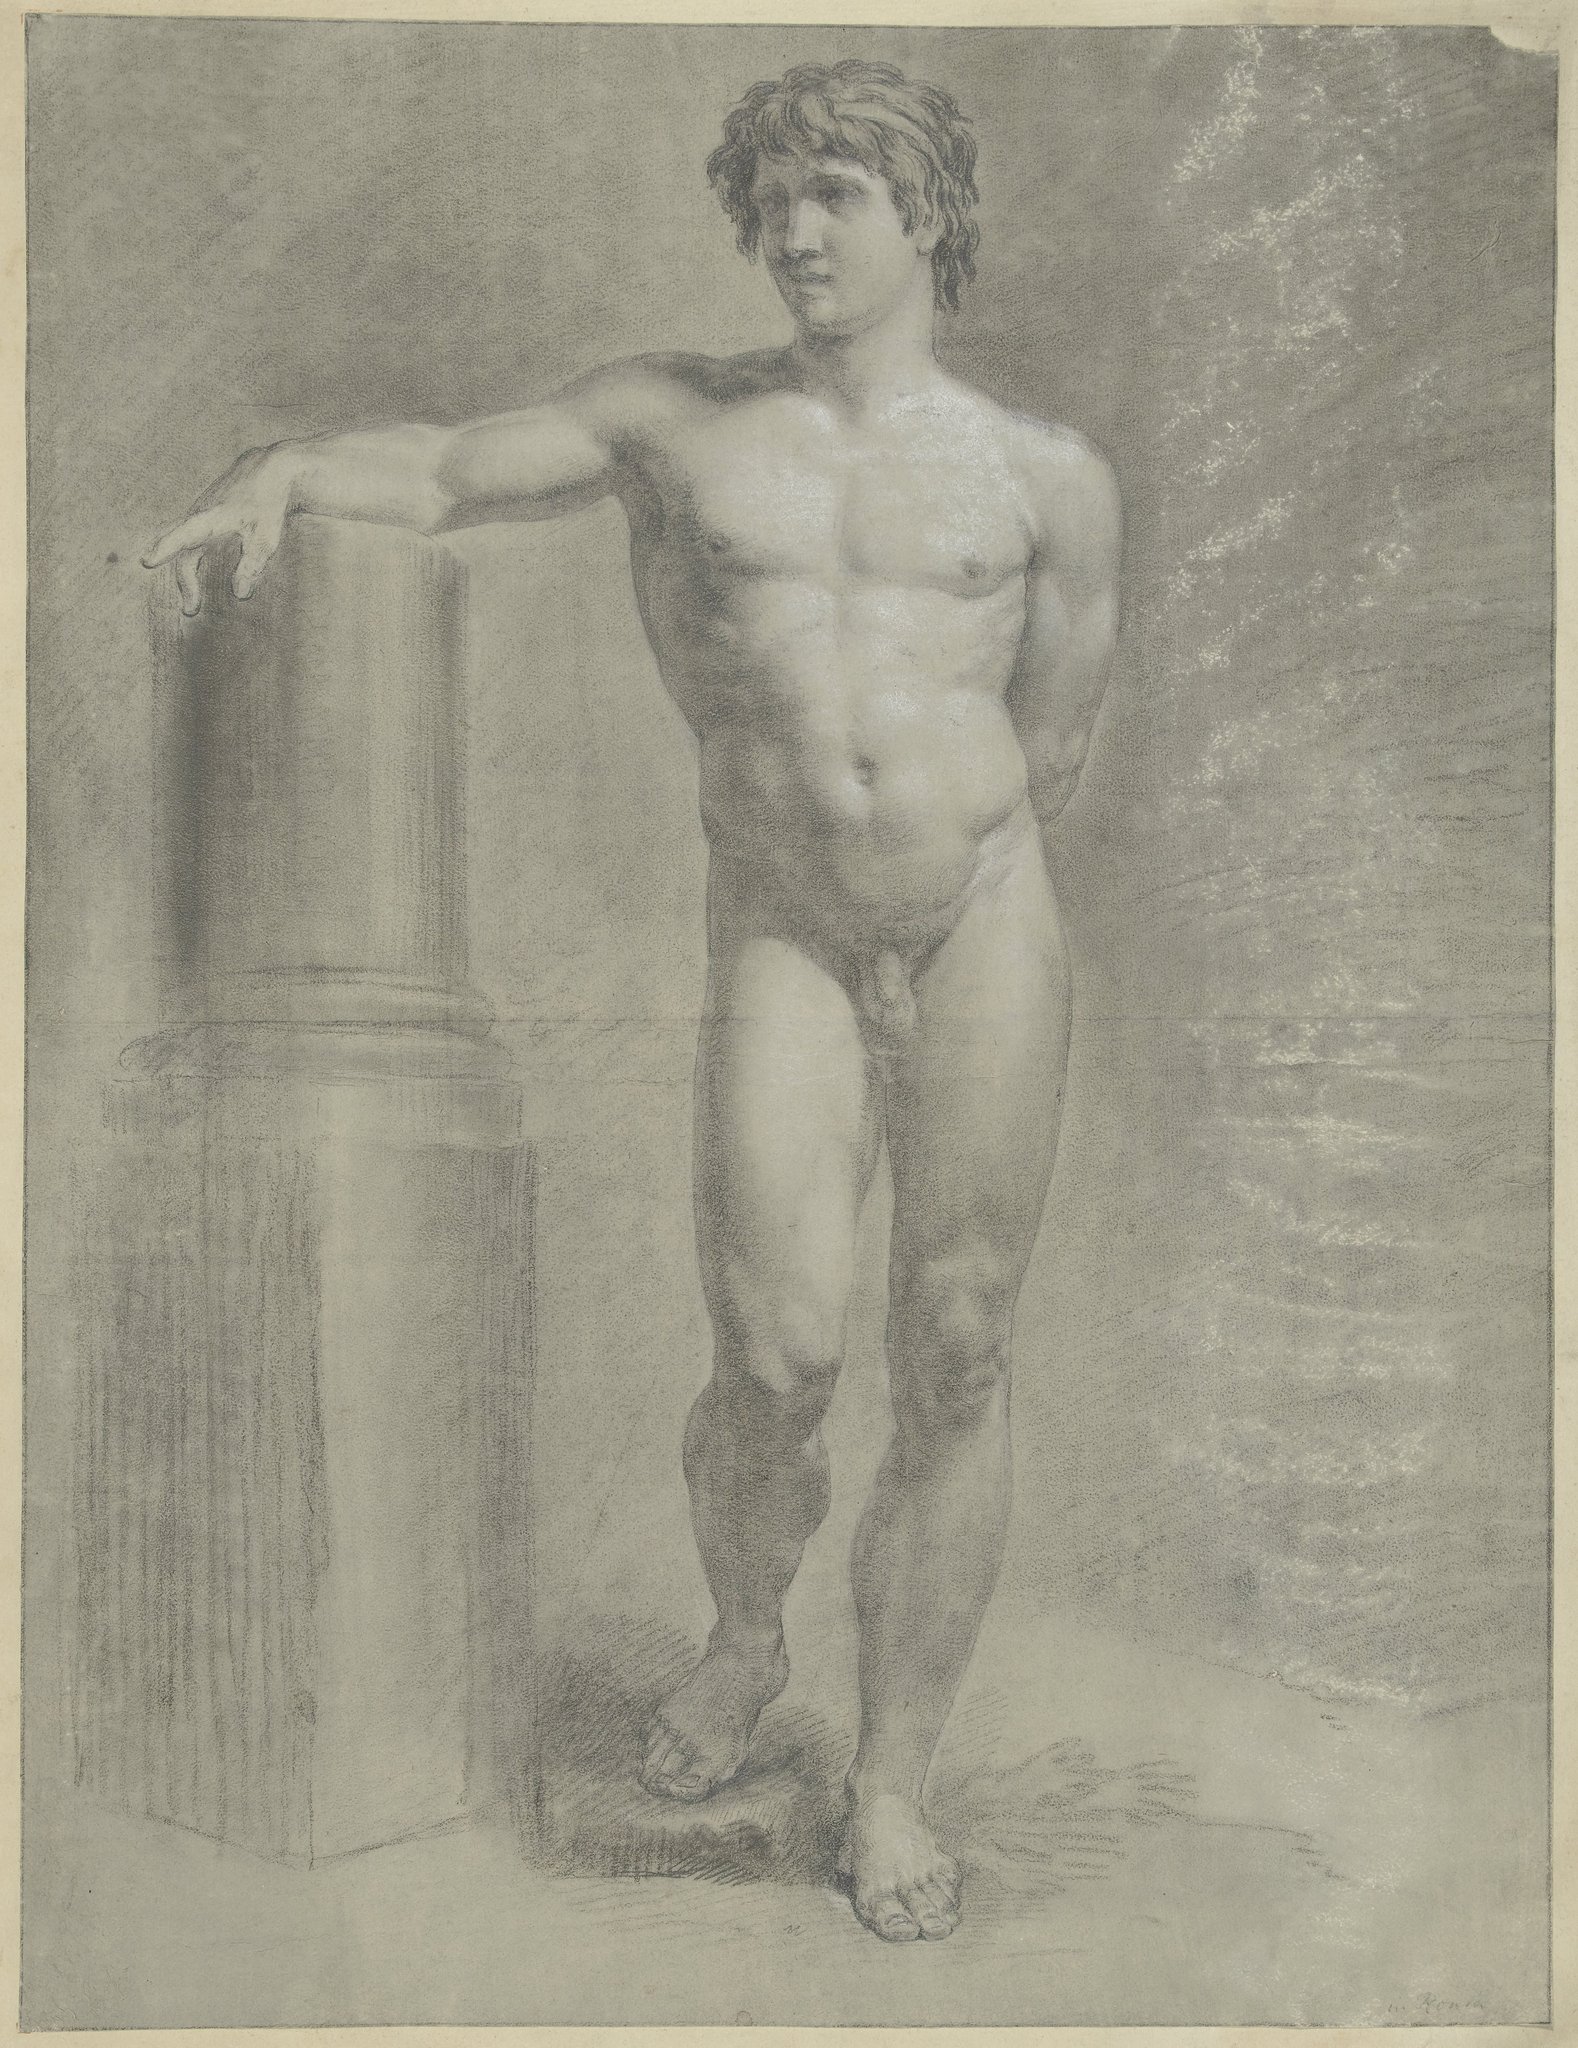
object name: drawing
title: Staand mannelijk naakt, de rechterarm op een afgebroken zuil, van voren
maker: jean grandjean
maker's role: draughtsman, print maker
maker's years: 1752-1781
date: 1765-1781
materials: chalk, paper